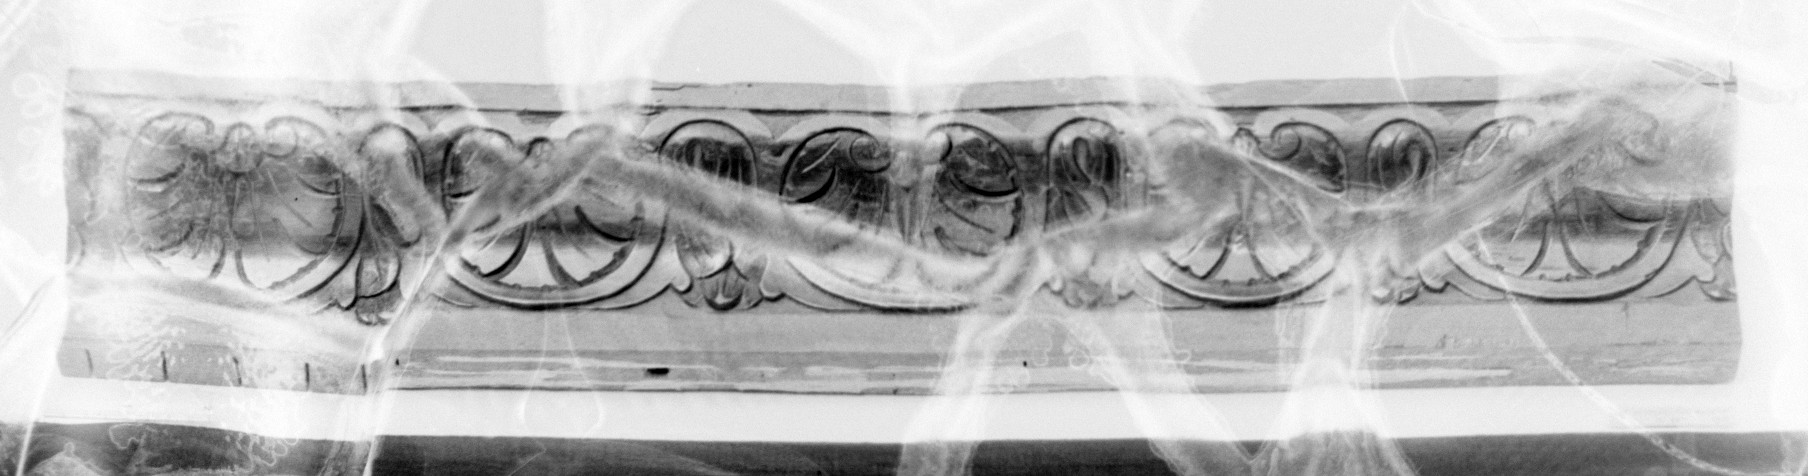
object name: molding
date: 1501-1600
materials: wood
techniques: carving